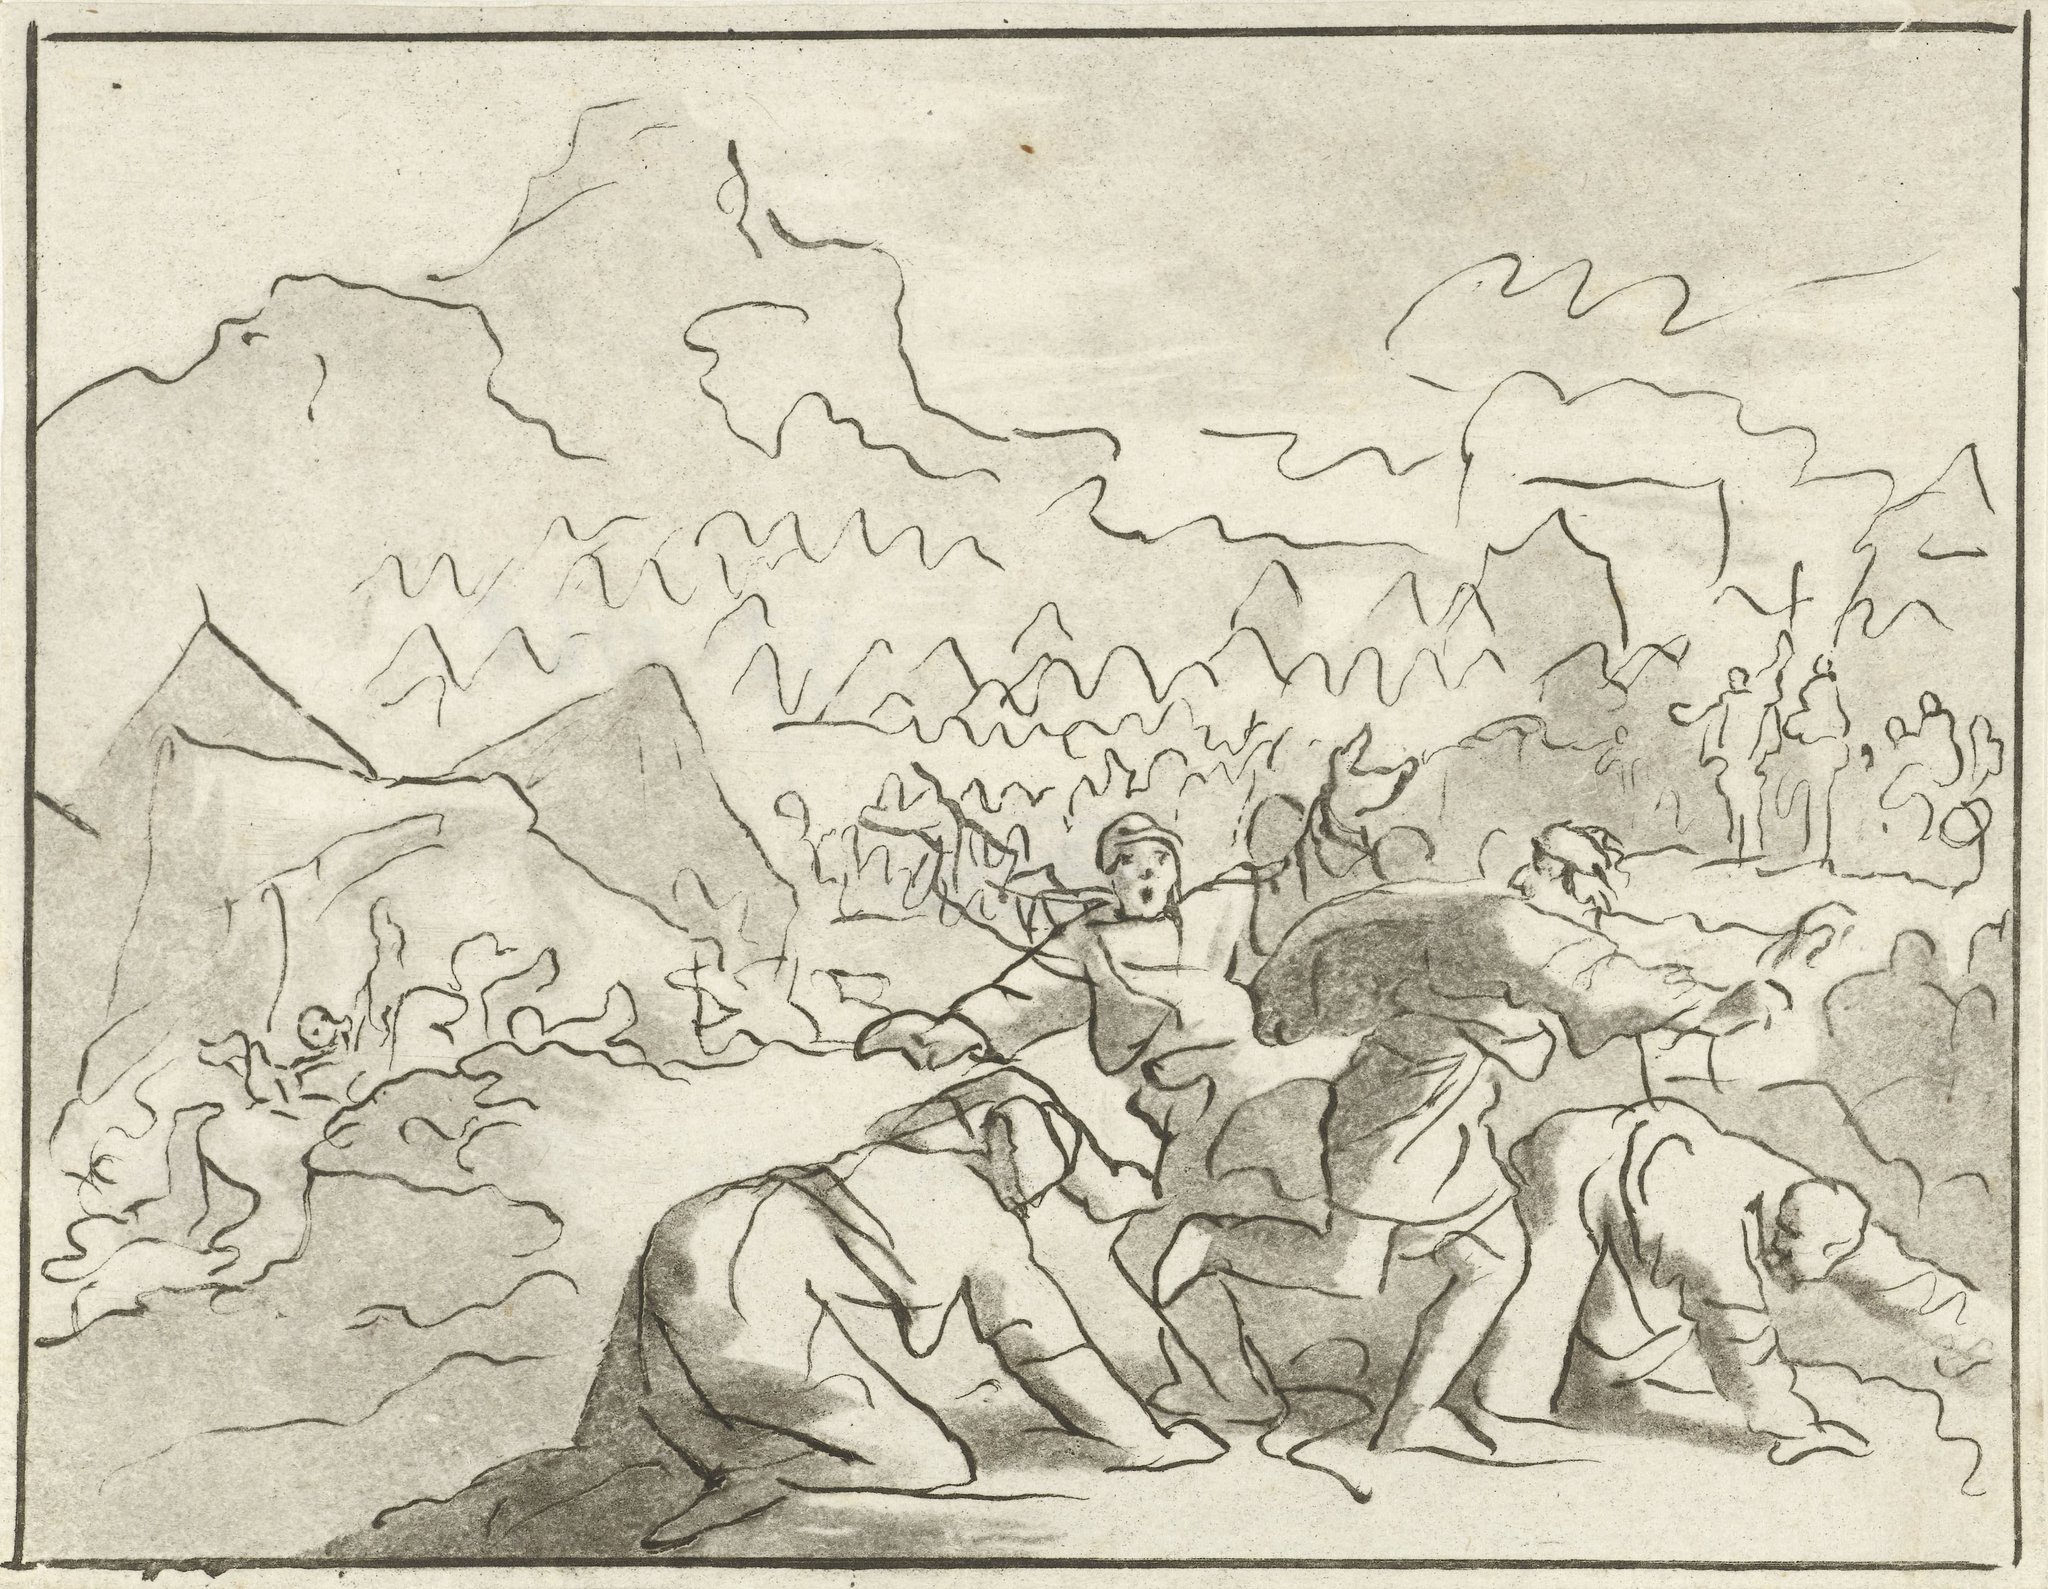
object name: print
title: Vluchtende personen, een kamp op de achtergrond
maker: benjamin martini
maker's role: print maker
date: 1777-1780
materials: paper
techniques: aquatint, etching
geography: amsterdam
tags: flight, running away; pursuing, tent-camp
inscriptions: collector's mark: Lugt 2228, collector's mark: Lugt 2760